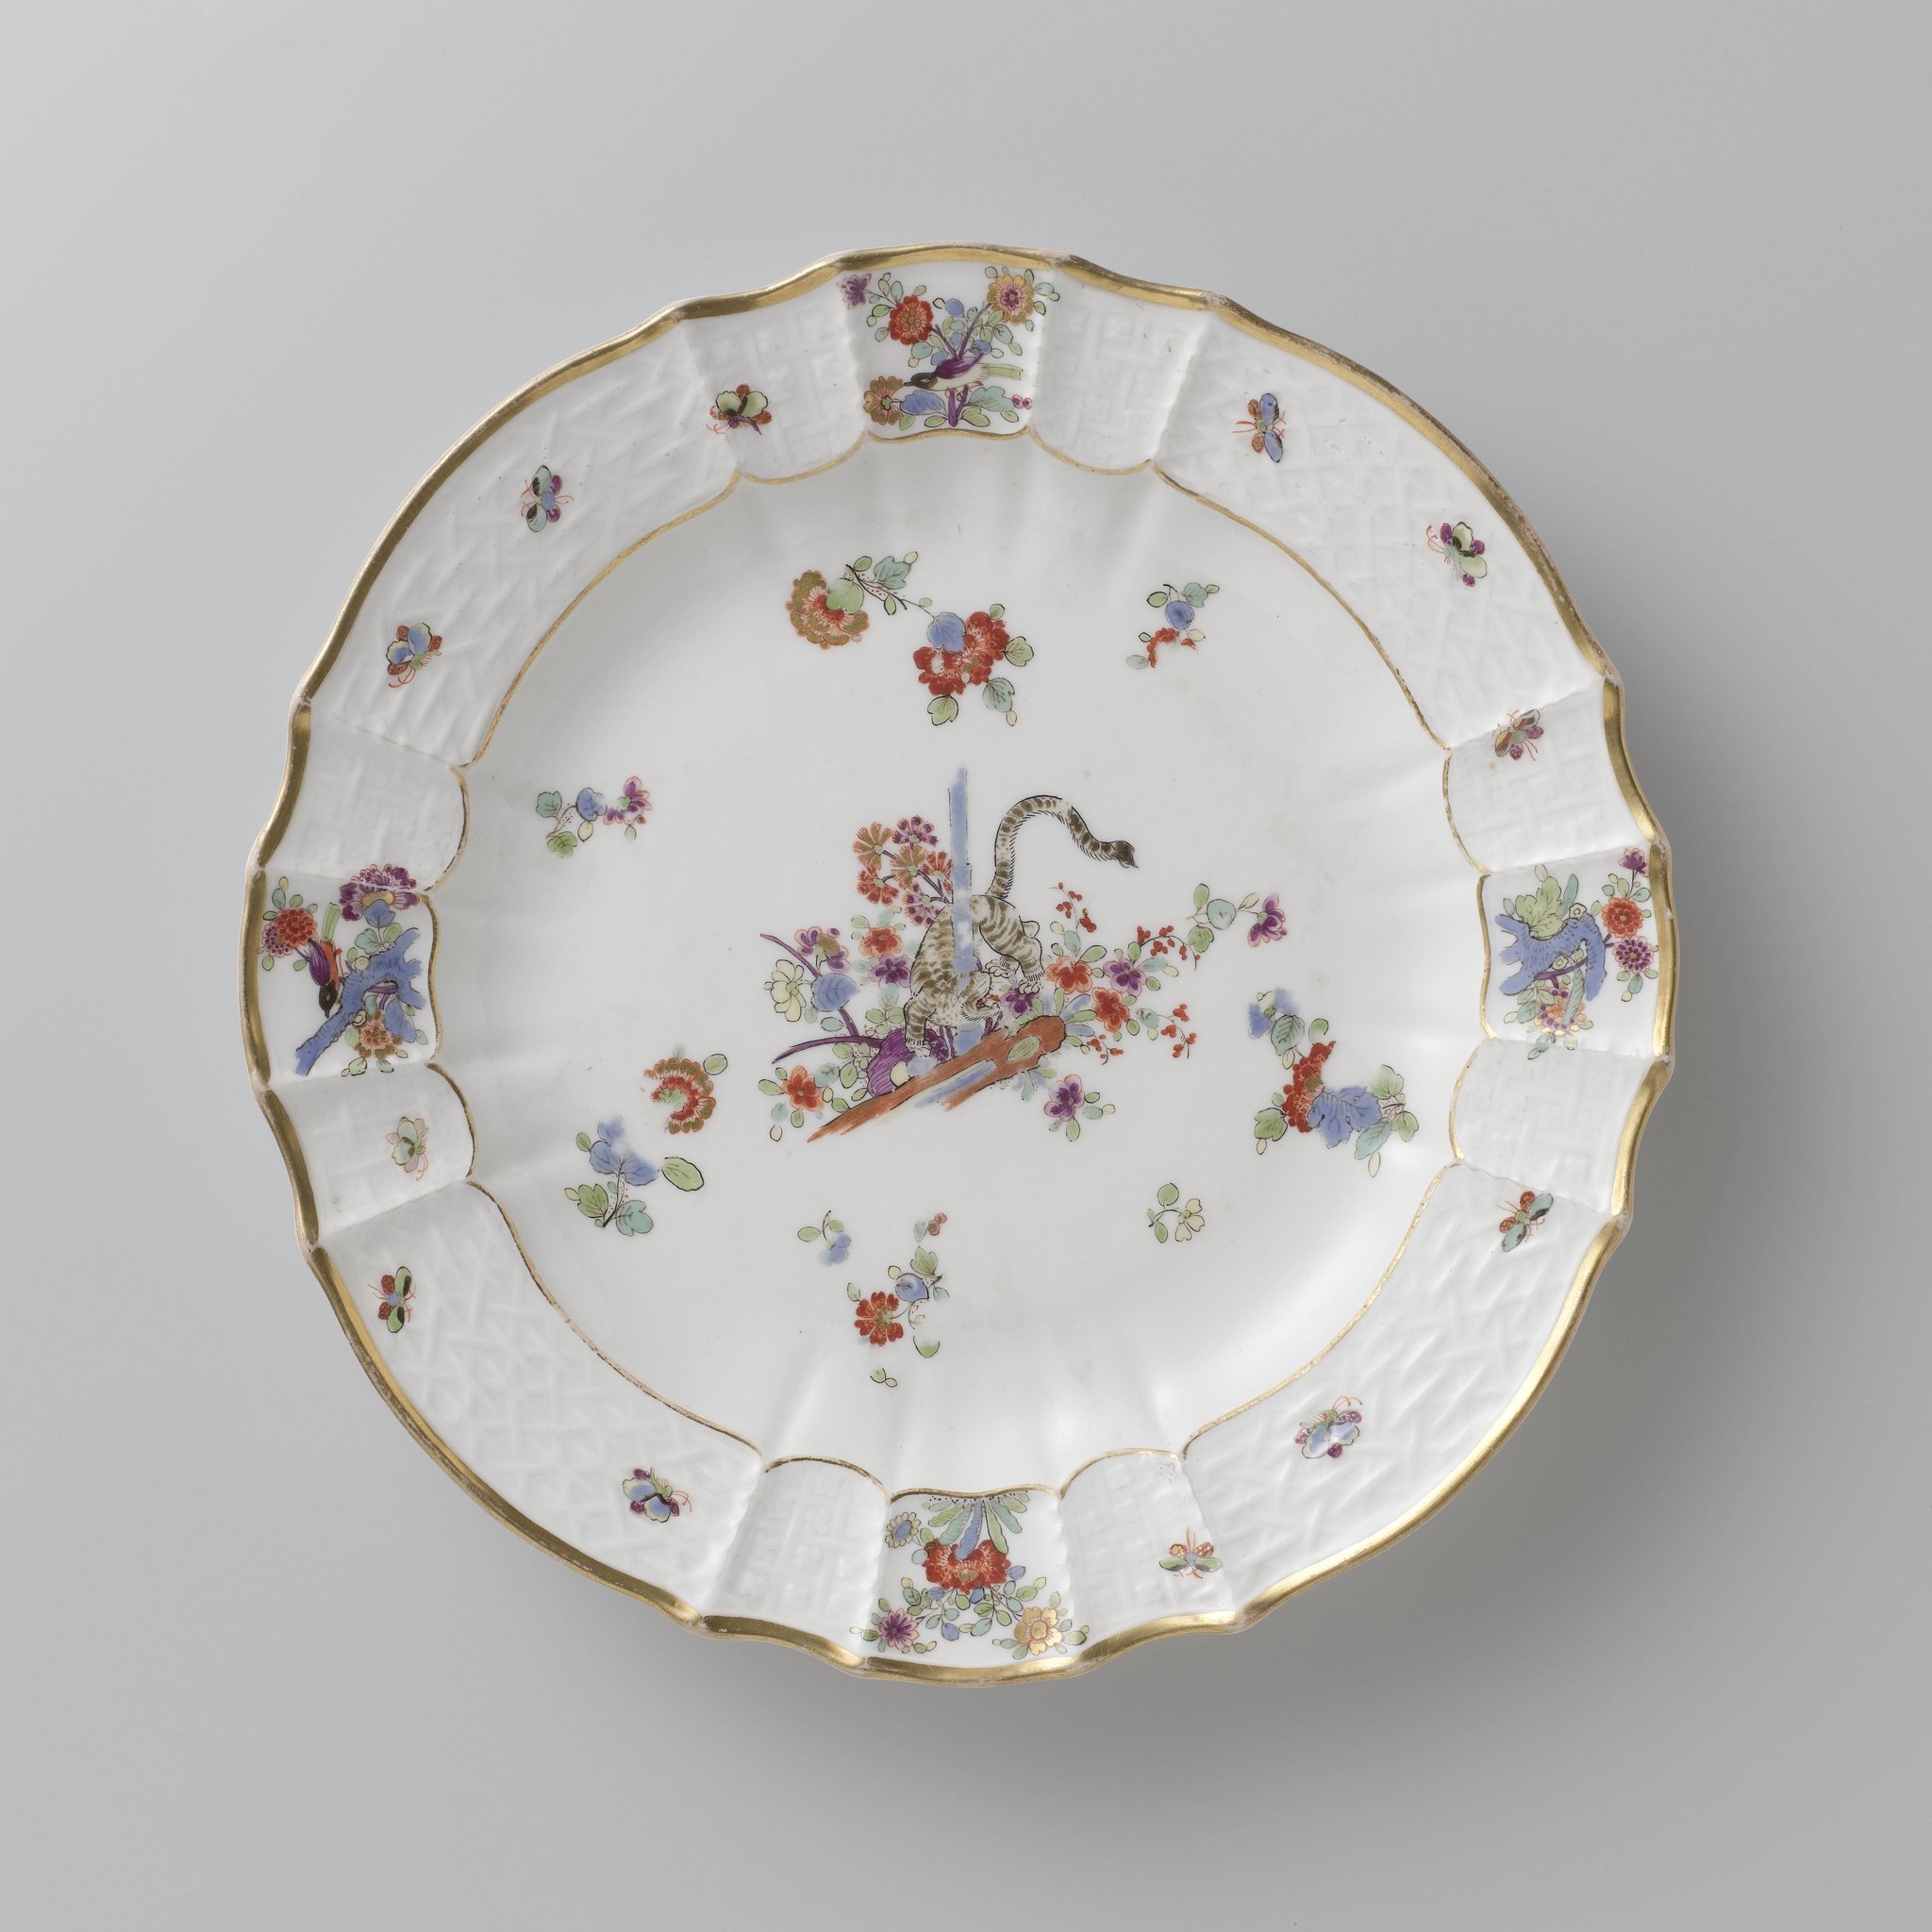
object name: plate dish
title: Rond bord, veelkleurig beschilderd met een Kakiemon-decor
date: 1740-1745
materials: porcelain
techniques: painted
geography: meissen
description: Rond bord van beschilderd porselein. Het bord is geribd en heeft een geschulpte rand. Het bord is beschilderd met een tijger die om een blauwe bamboestengel tussen bloemen is gedraaid, gestrooide Indianische Blumen, vlinders en takken waarop vogels. De rand is versierd met het 'Altbrandenstein'-patroon. Het bord is gemerkt.